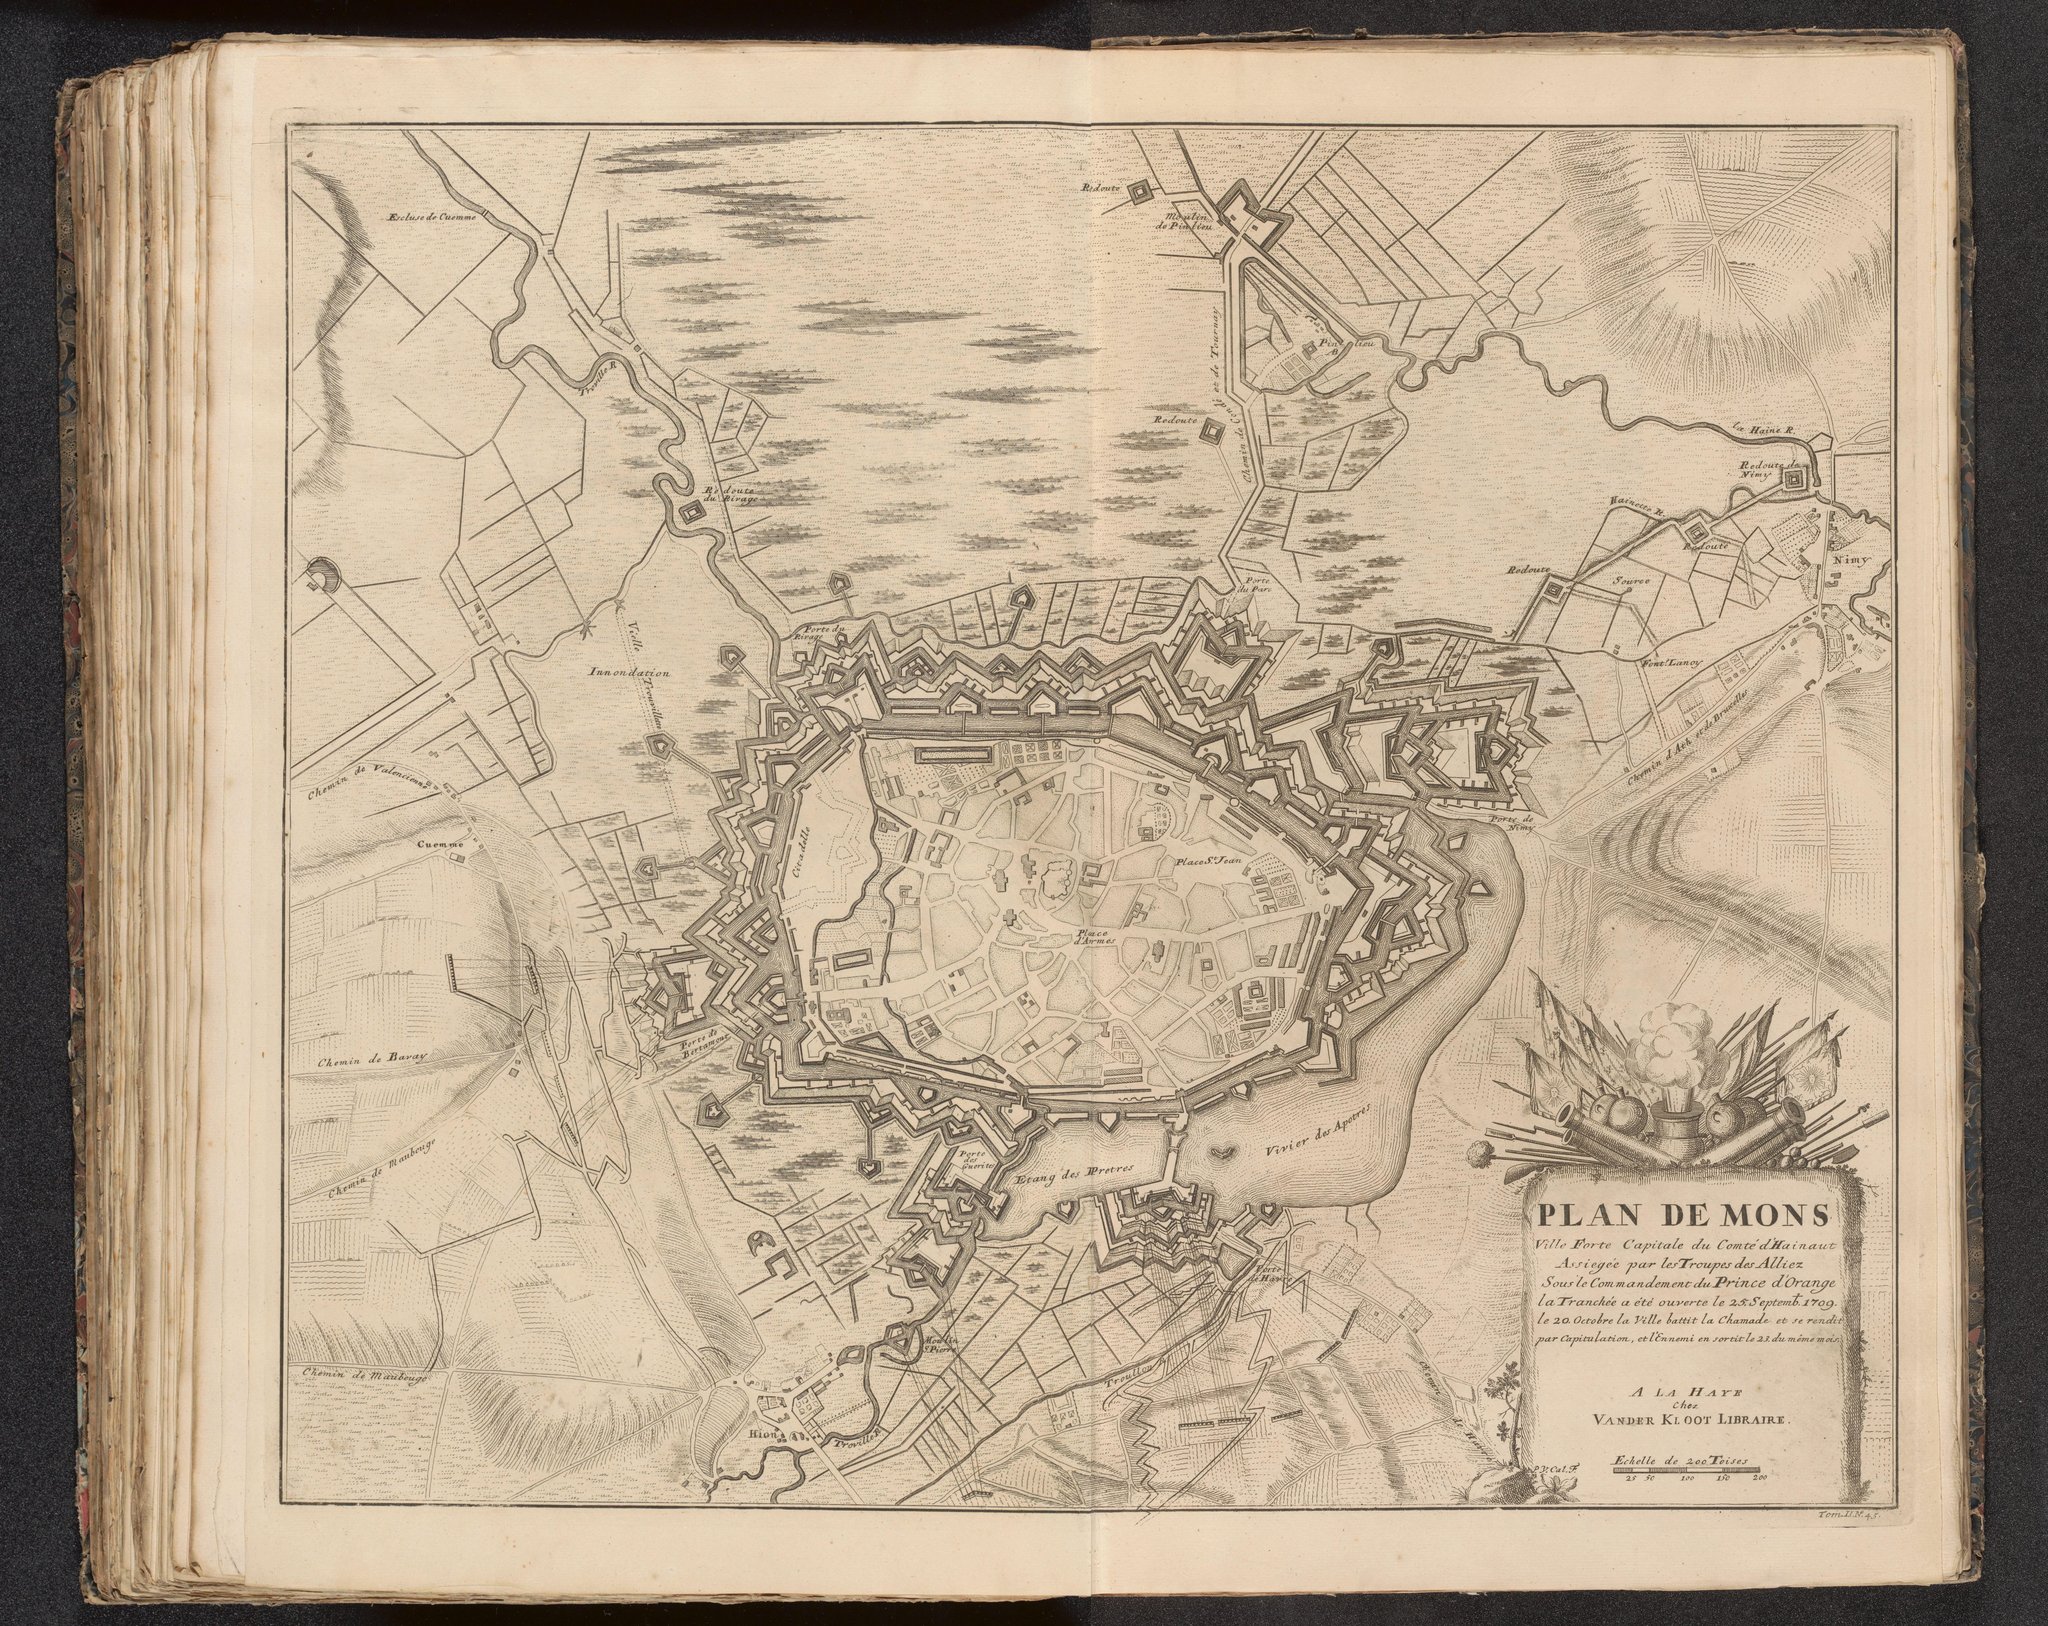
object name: map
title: Plan de Mons Ville Forte Capitale du Comté d'Hainaut Assiegée par les Troupes des Alliez Sous le Commandement du Prince d'Orange (...)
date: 1709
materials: paper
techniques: etching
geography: the hague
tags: johan willem friso (prins van oranje-nassau), john churchill (1e hertog van marlborough), siege, position war, maps of cities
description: Kaart van het beleg van Mons (Bergen) door de Geallieerden onder de prins van Oranje vanaf 25 september en ingenomen op 23 oktober 1709. Genummerd rechtsonder: Tom. II. No. 45. Illustratie in het tweede deel van : [Jean] du Mont, Oorlogskundige beschryving van de veldslagen en belegeringen, der drie ... wydvermaarde krygsoversten... den Prins Eugenius van Savoye, den ... Hertog van Marlborough, en den Prins van Oranje en Nassau-Vriesland, in de editie van 1729. Dit tweede deel is hoofdzakelijk gewijd aan de daden van de hertog van Marlborough en prins Johan Willem Friso.